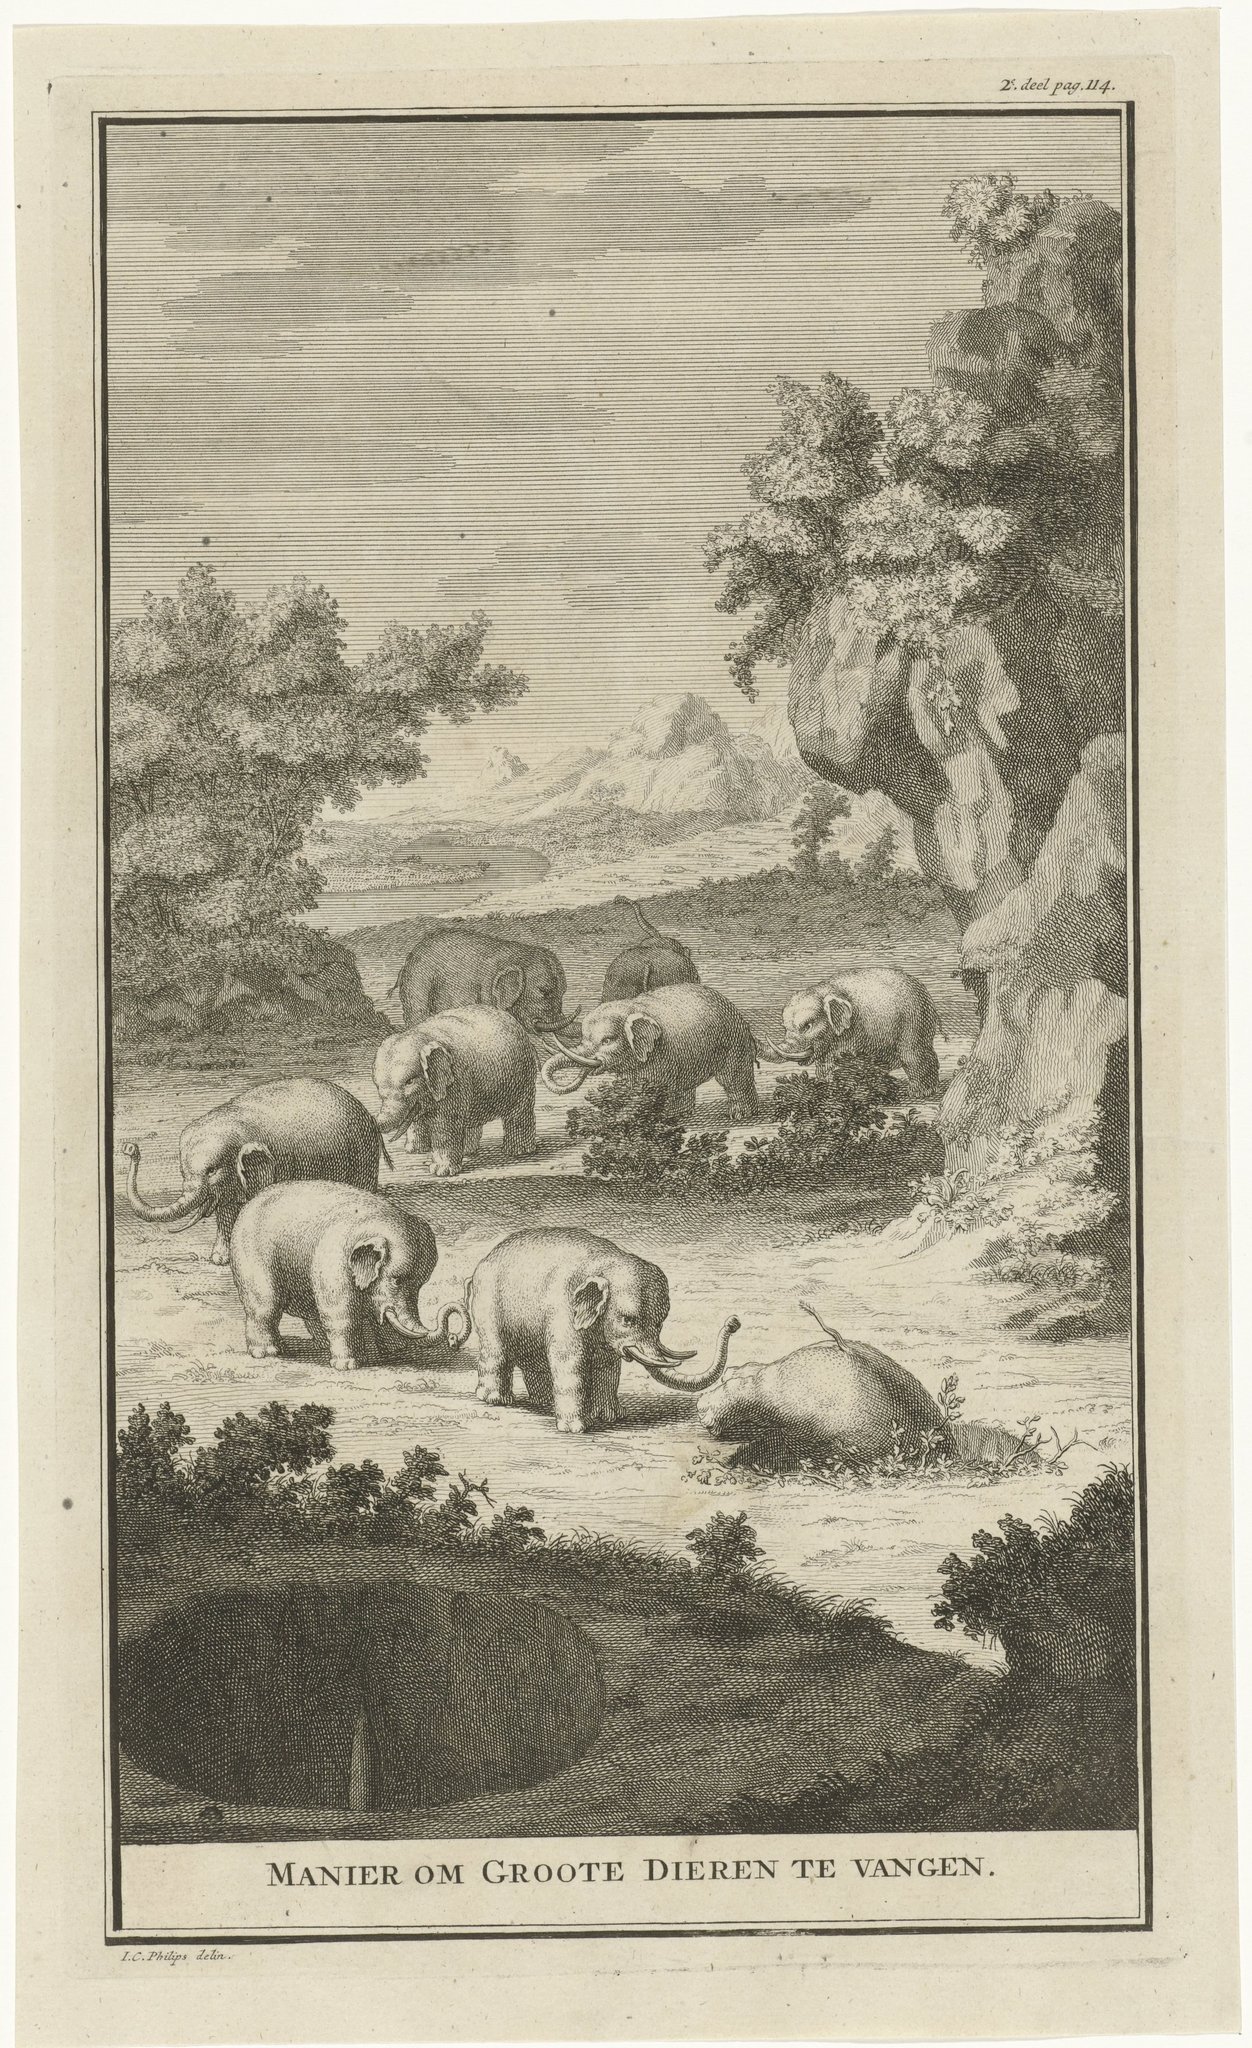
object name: book illustration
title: Manier om Groote Dieren te vangen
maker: jan caspar philips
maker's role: draughtsman, print maker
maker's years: 1700-1775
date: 1727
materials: paper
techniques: engraving, etching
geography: amsterdam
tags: hunt ~ mammals, khoikhoi, trunked animals: elephant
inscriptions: collector's mark: Lugt 2228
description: Prent als illustratie gebruikt in: Kolbe, Peter. Naaukeurige en uitvoerige beschryving van de kaap de Goede Hoop; behelzende een zeer omstandig verhaal van den tegenwoordigen toestant van dat vermaarde gewest ... beschryving van de oorsprong der Hottentotten, deel II, p. 114. Amsterdam: Balthazar Lakeman, 1727.